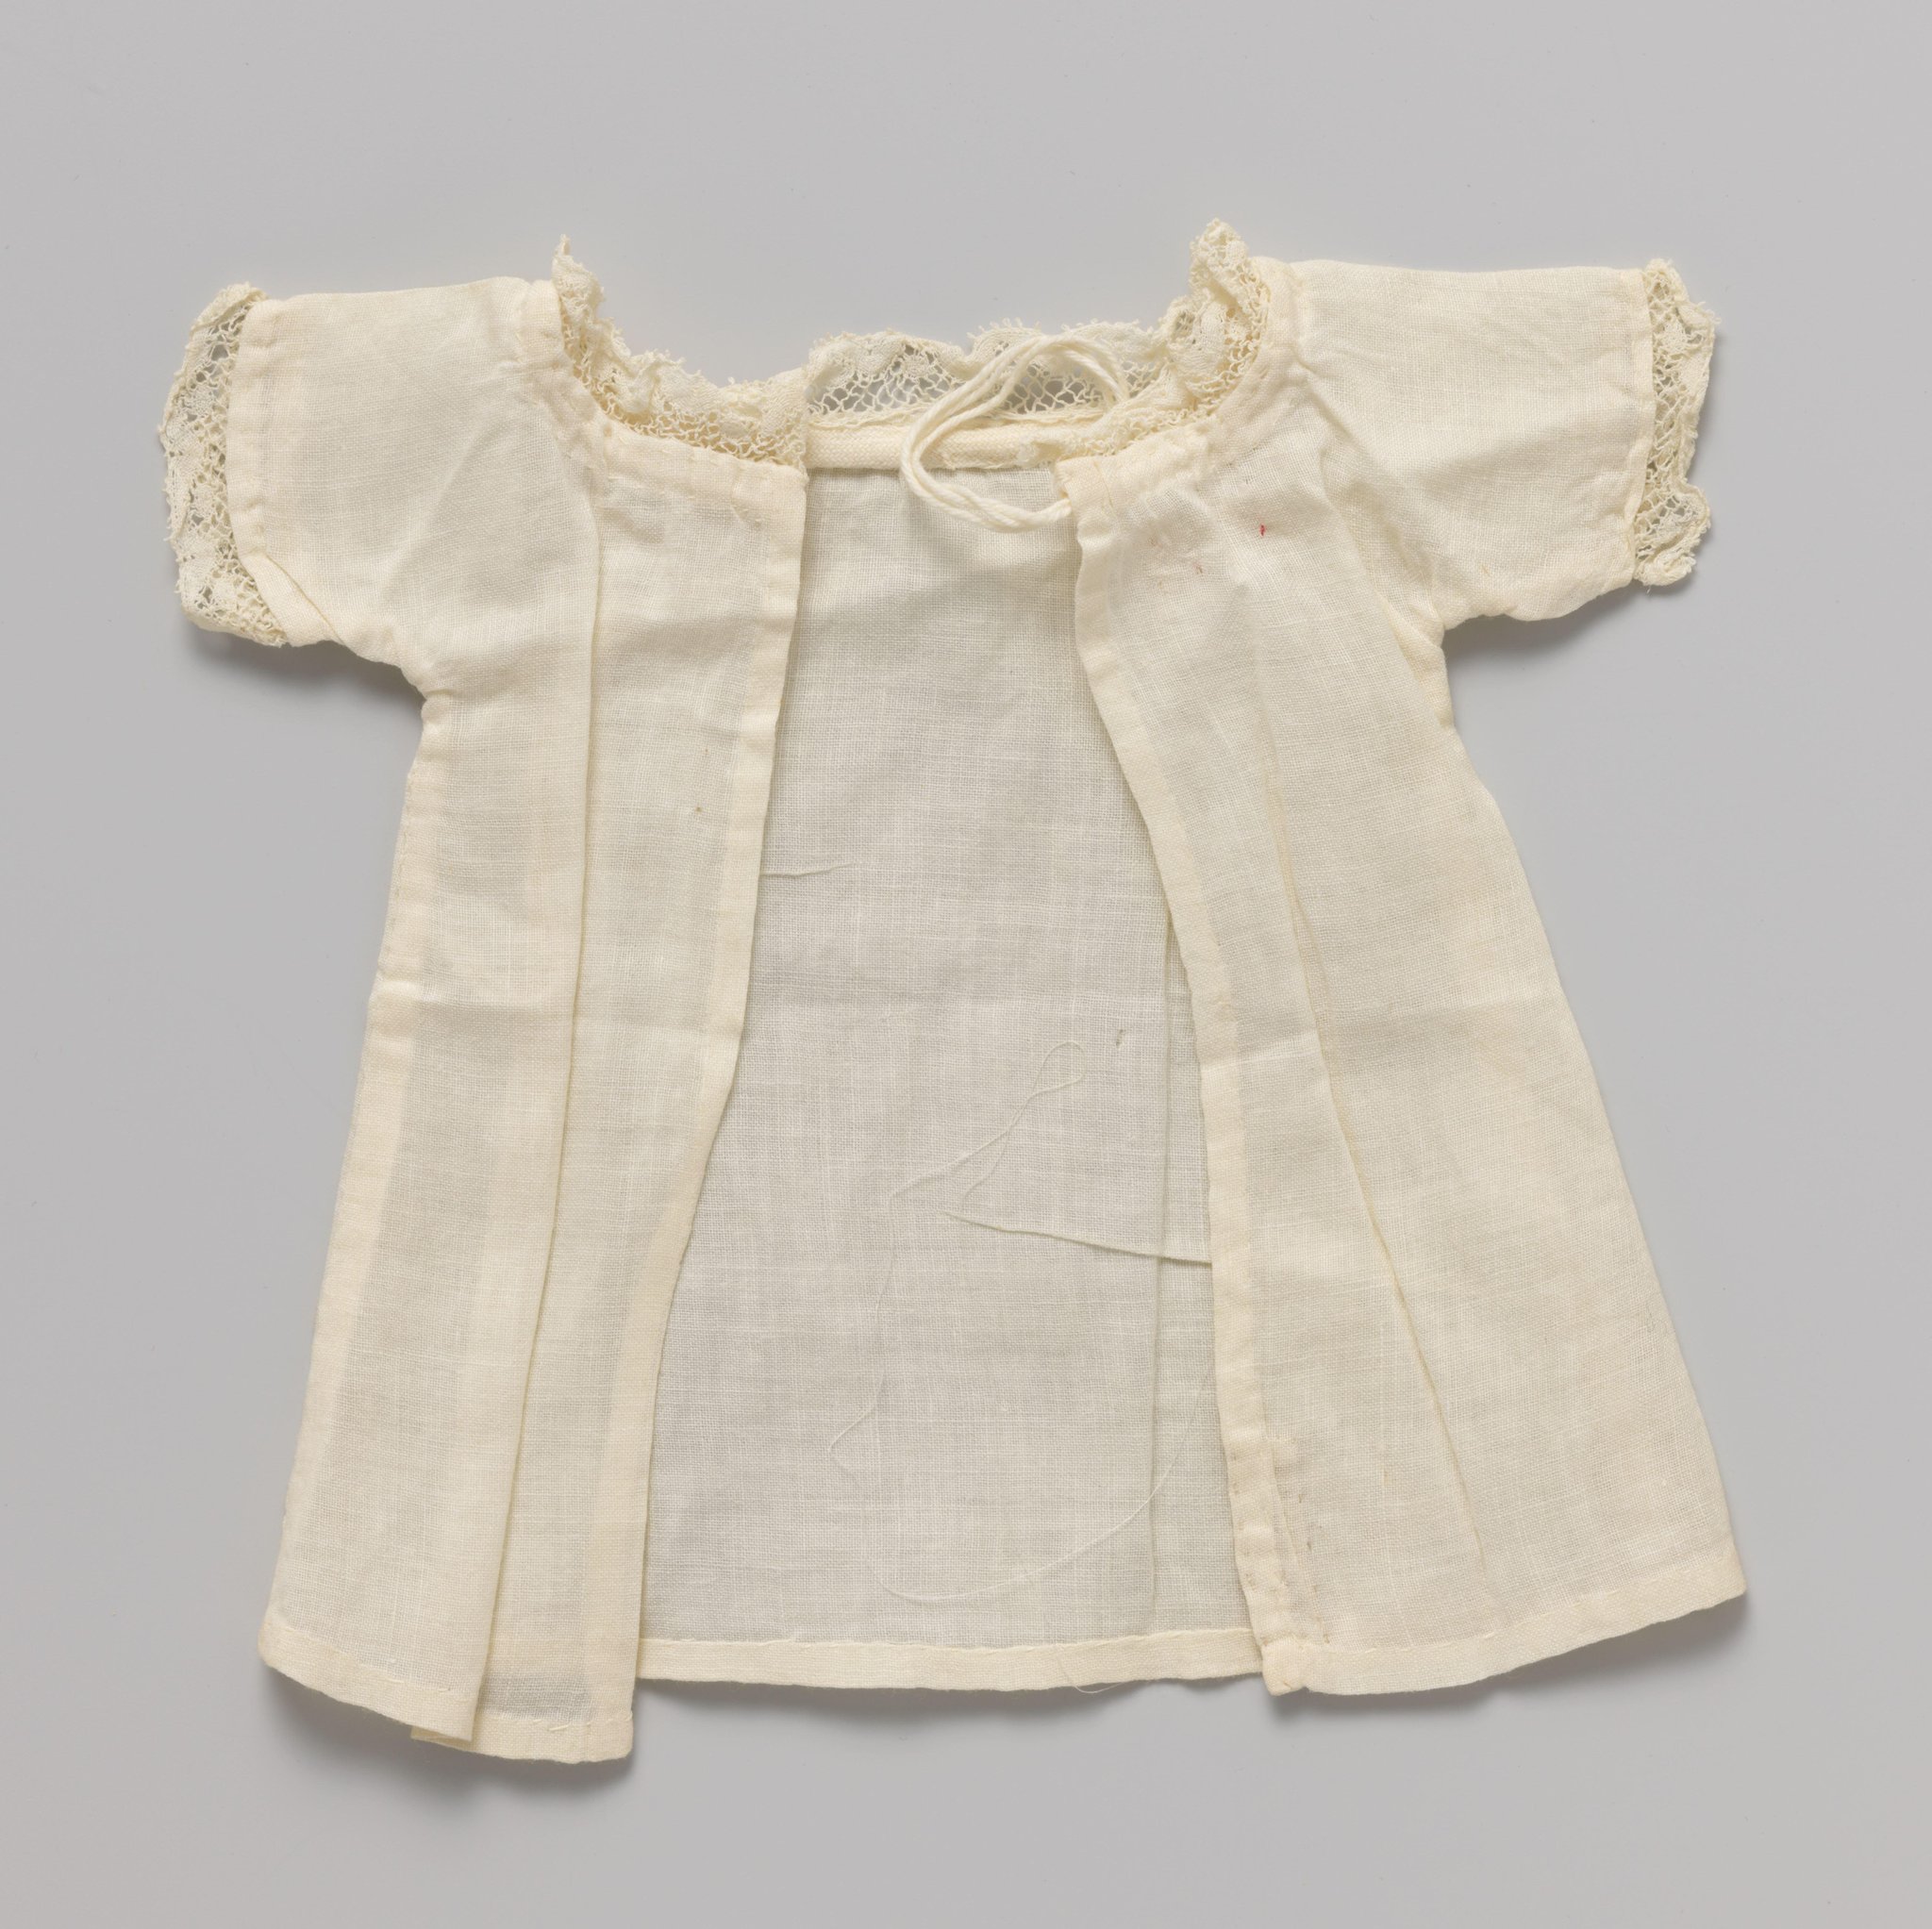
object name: doll's clothing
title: Hemd voor een bakerpop. Hals en mouwen afgezet met Valenciennes kant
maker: Anonymous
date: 1800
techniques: lace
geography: netherlands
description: Hemd voor een bakerpop. Hals en mouwen afgezet met kant, type Valenciennes.